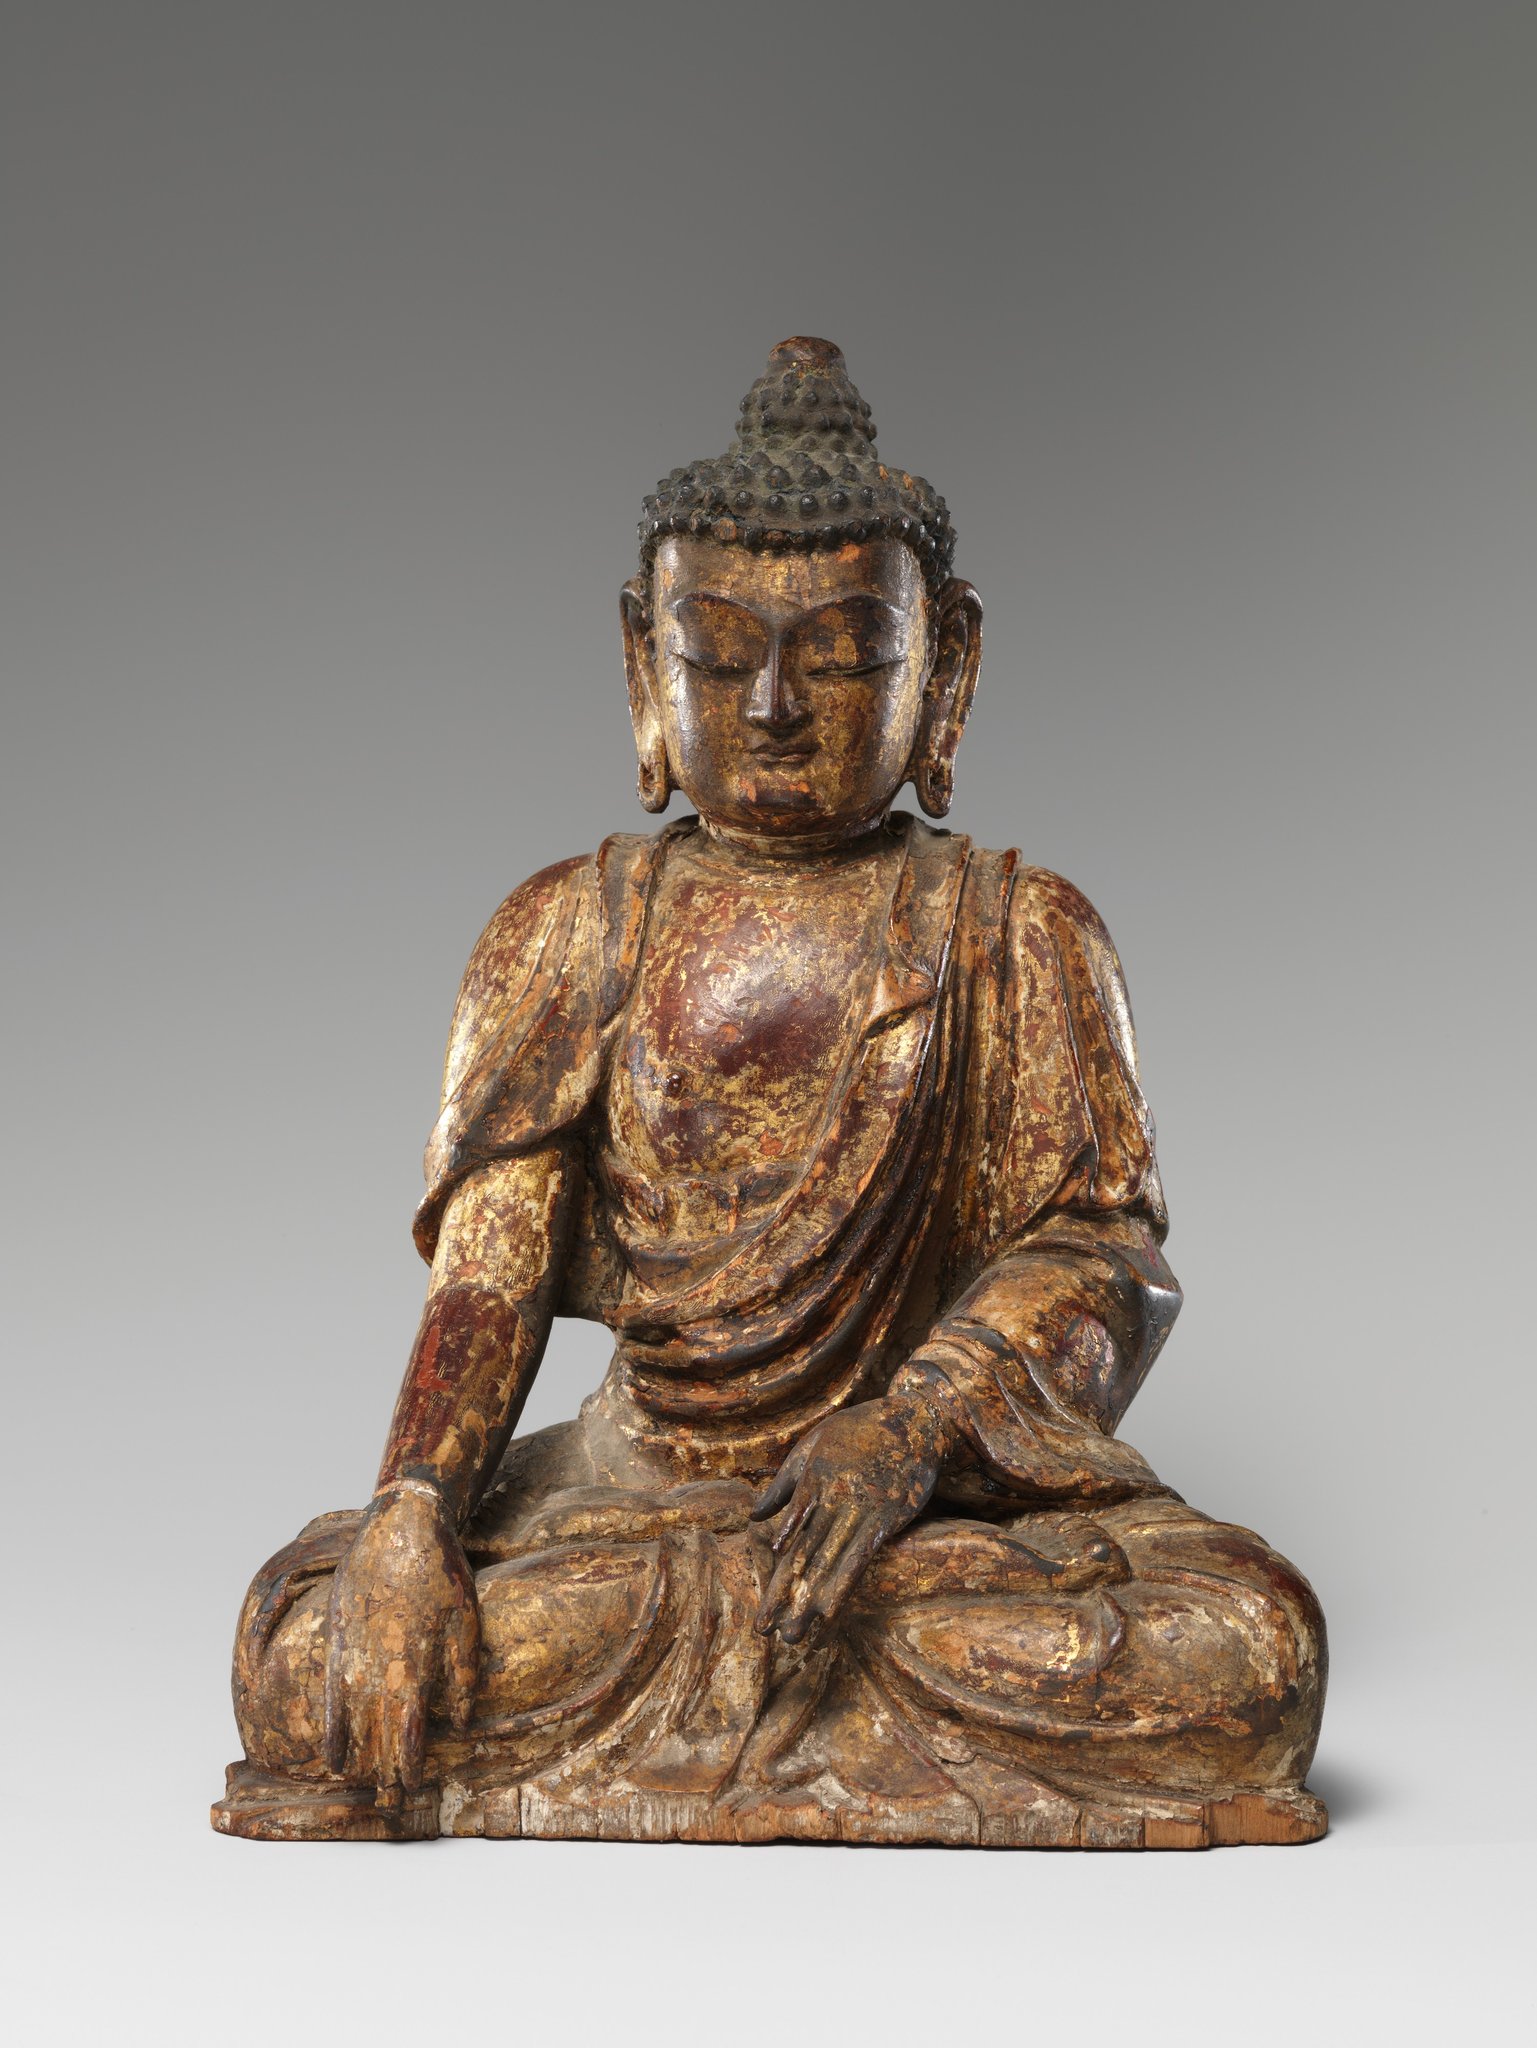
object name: figure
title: Seated Buddha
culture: chinese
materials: wood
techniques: gilding, lacquer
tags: buddha